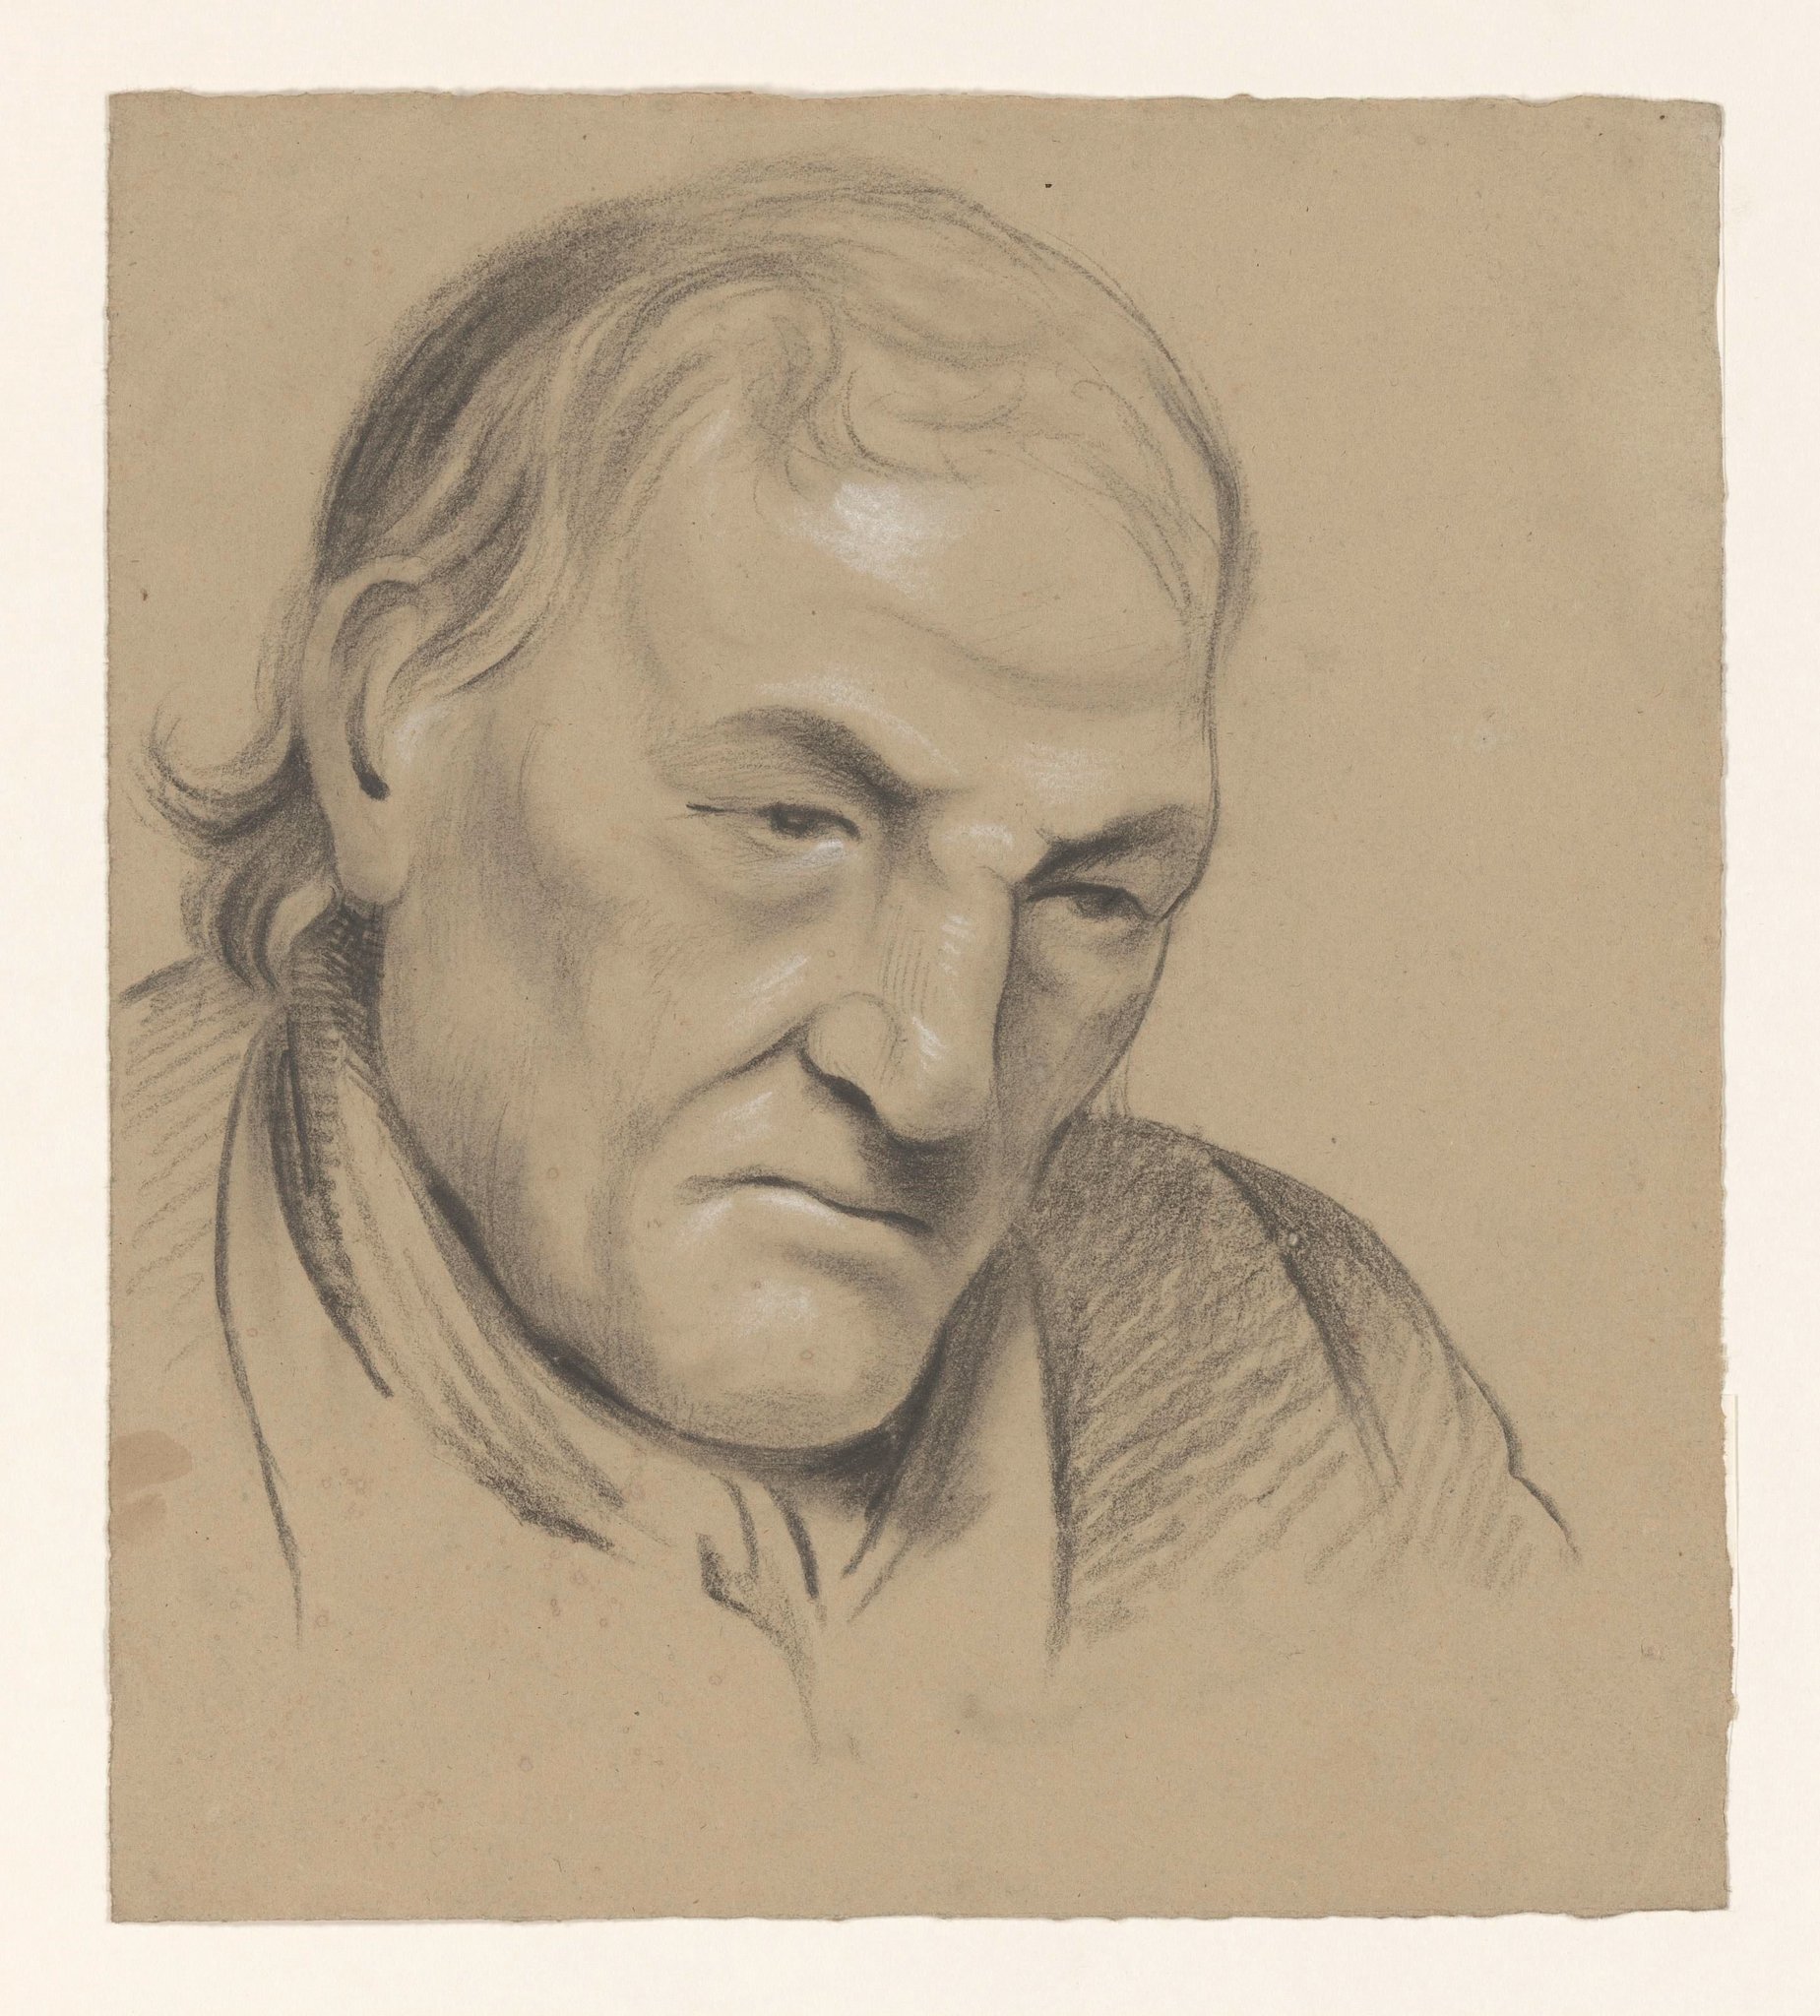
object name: drawing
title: Zittende man met ontbloot bovenlijf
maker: alexander cranendoncq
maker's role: draughtsman, print maker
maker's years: 1799-1869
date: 1809-1869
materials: chalk, paper